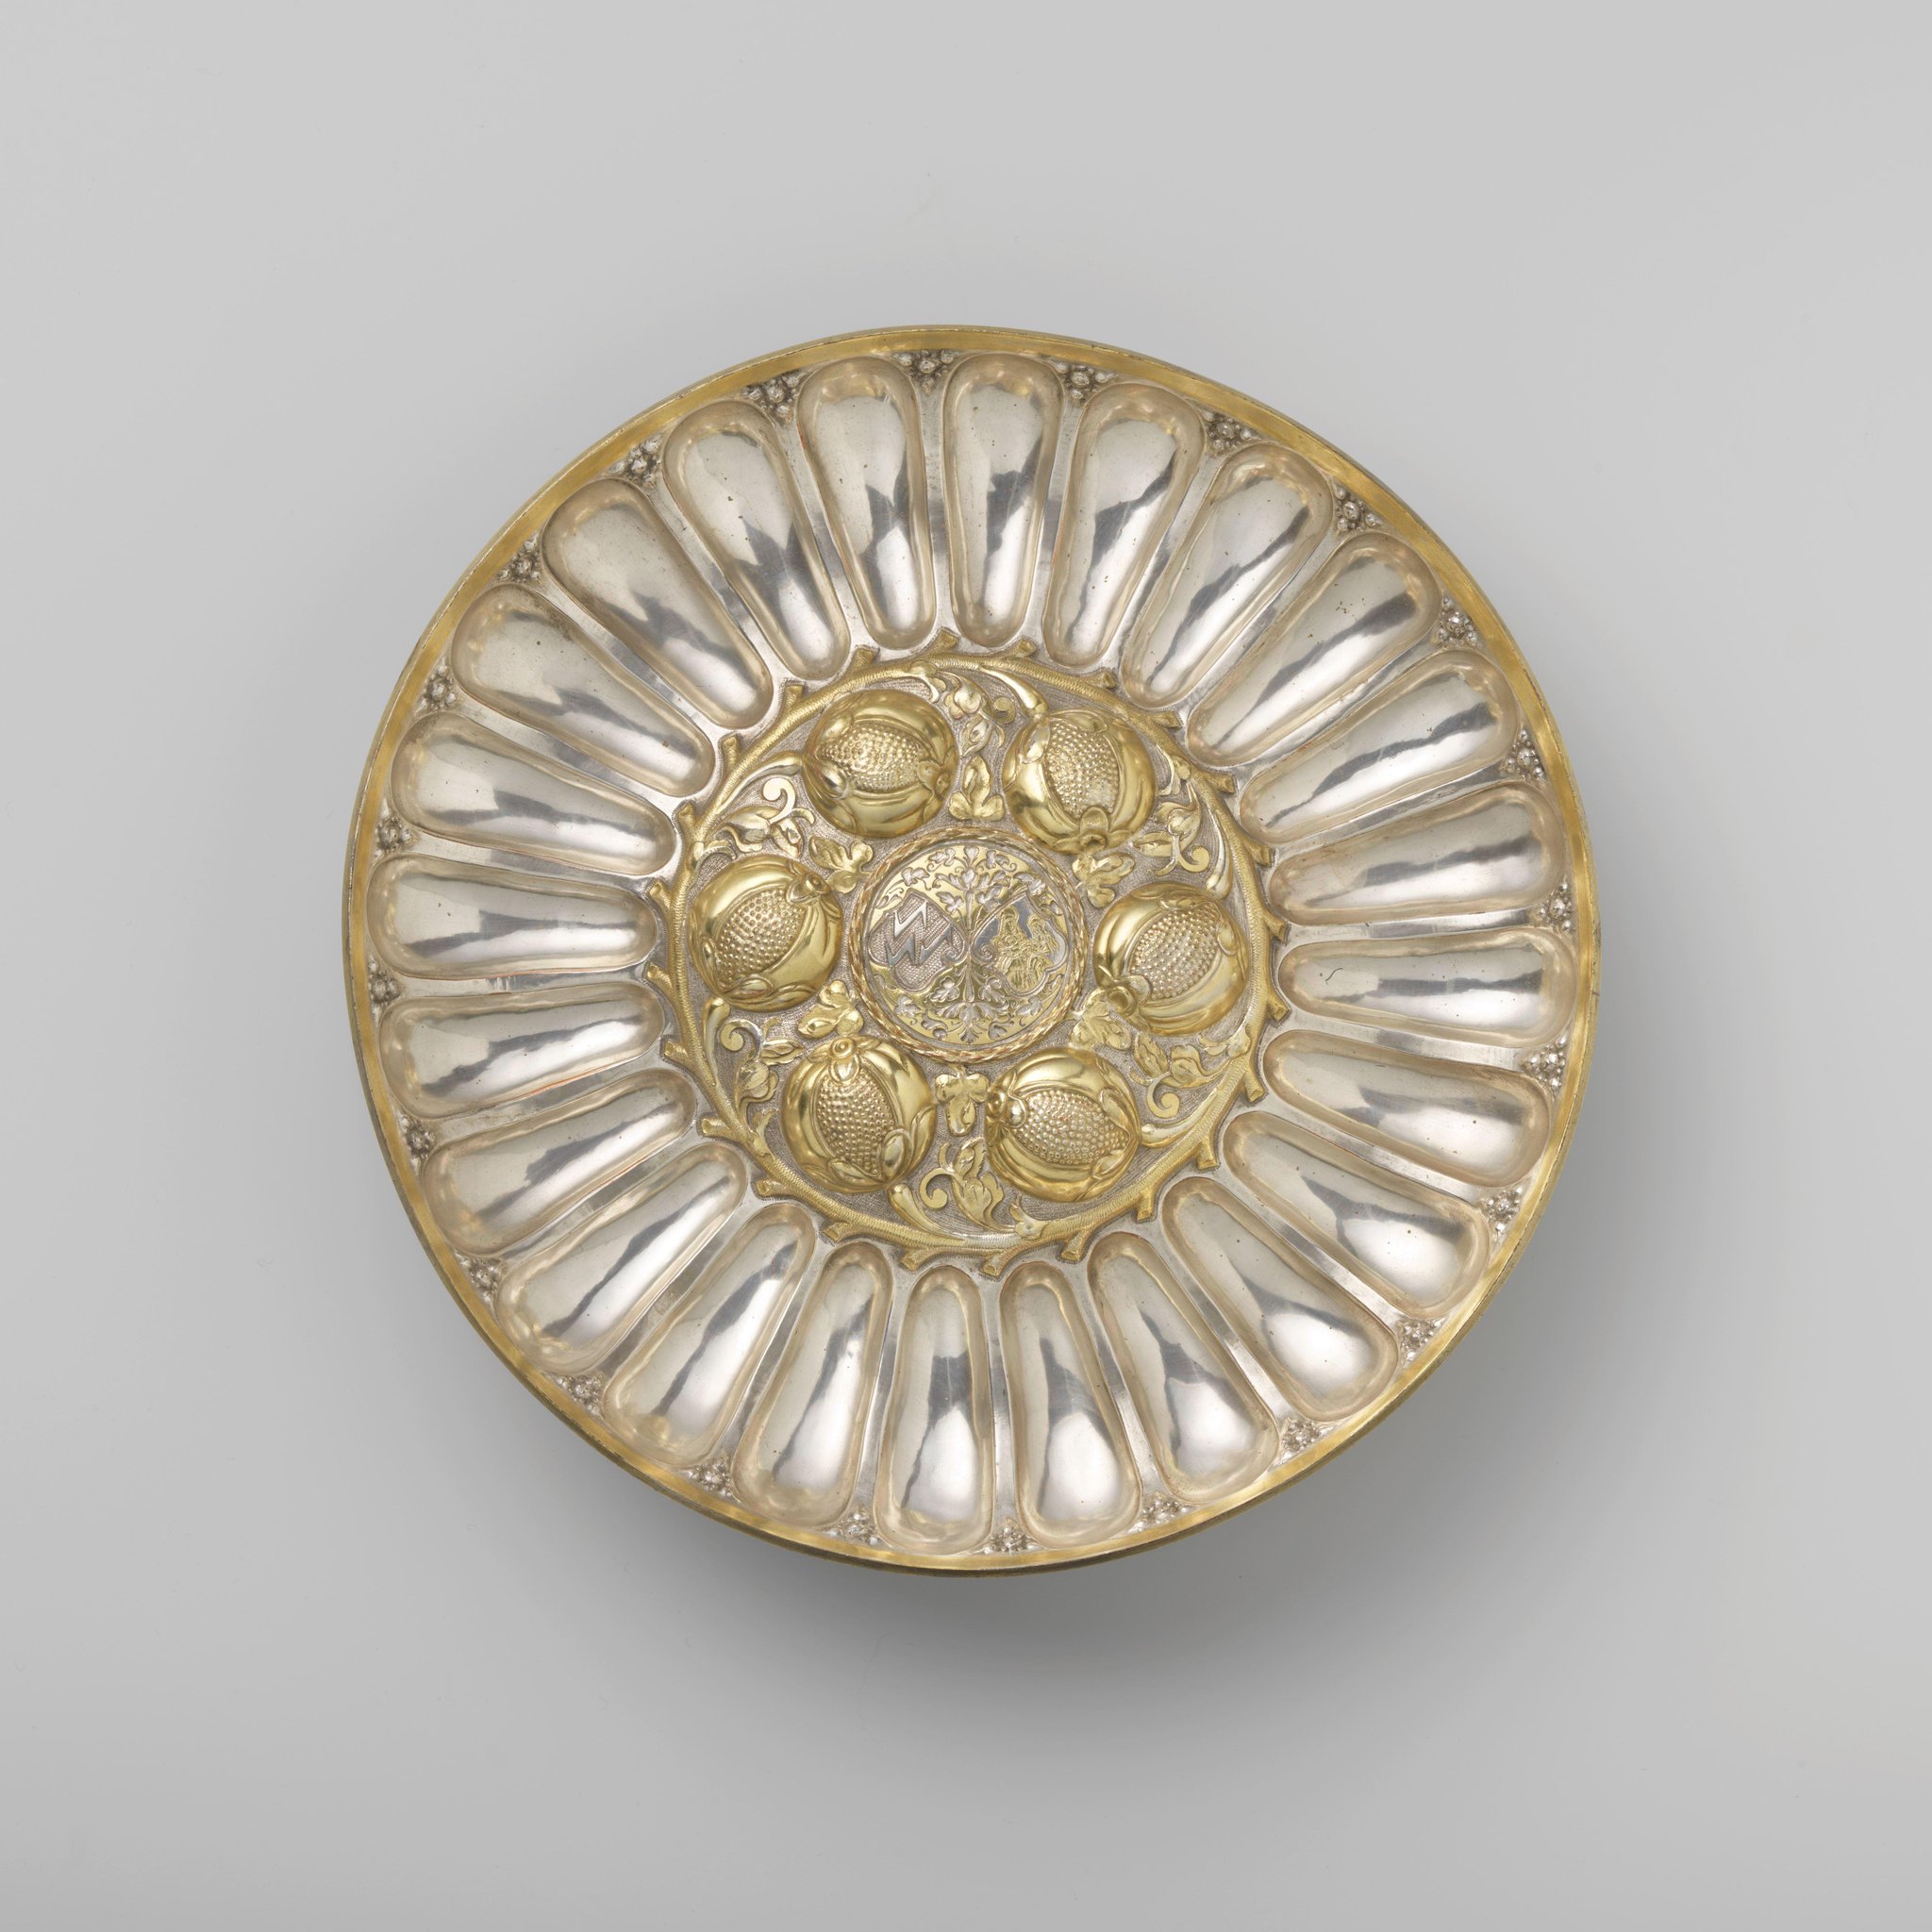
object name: dish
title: Galvanoplastische reproductie van de schaal op drie granaatappels uit het Lüneburger Ratssilber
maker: Anonymous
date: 1535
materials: copper, silver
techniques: gilding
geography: lüneburg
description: Galvanoplastische reproductie van een schaal op drie poten in de vorm van granaatappels. In het midden van de schaal twee burgerwapens in email. Gedeeltelijk verguld.